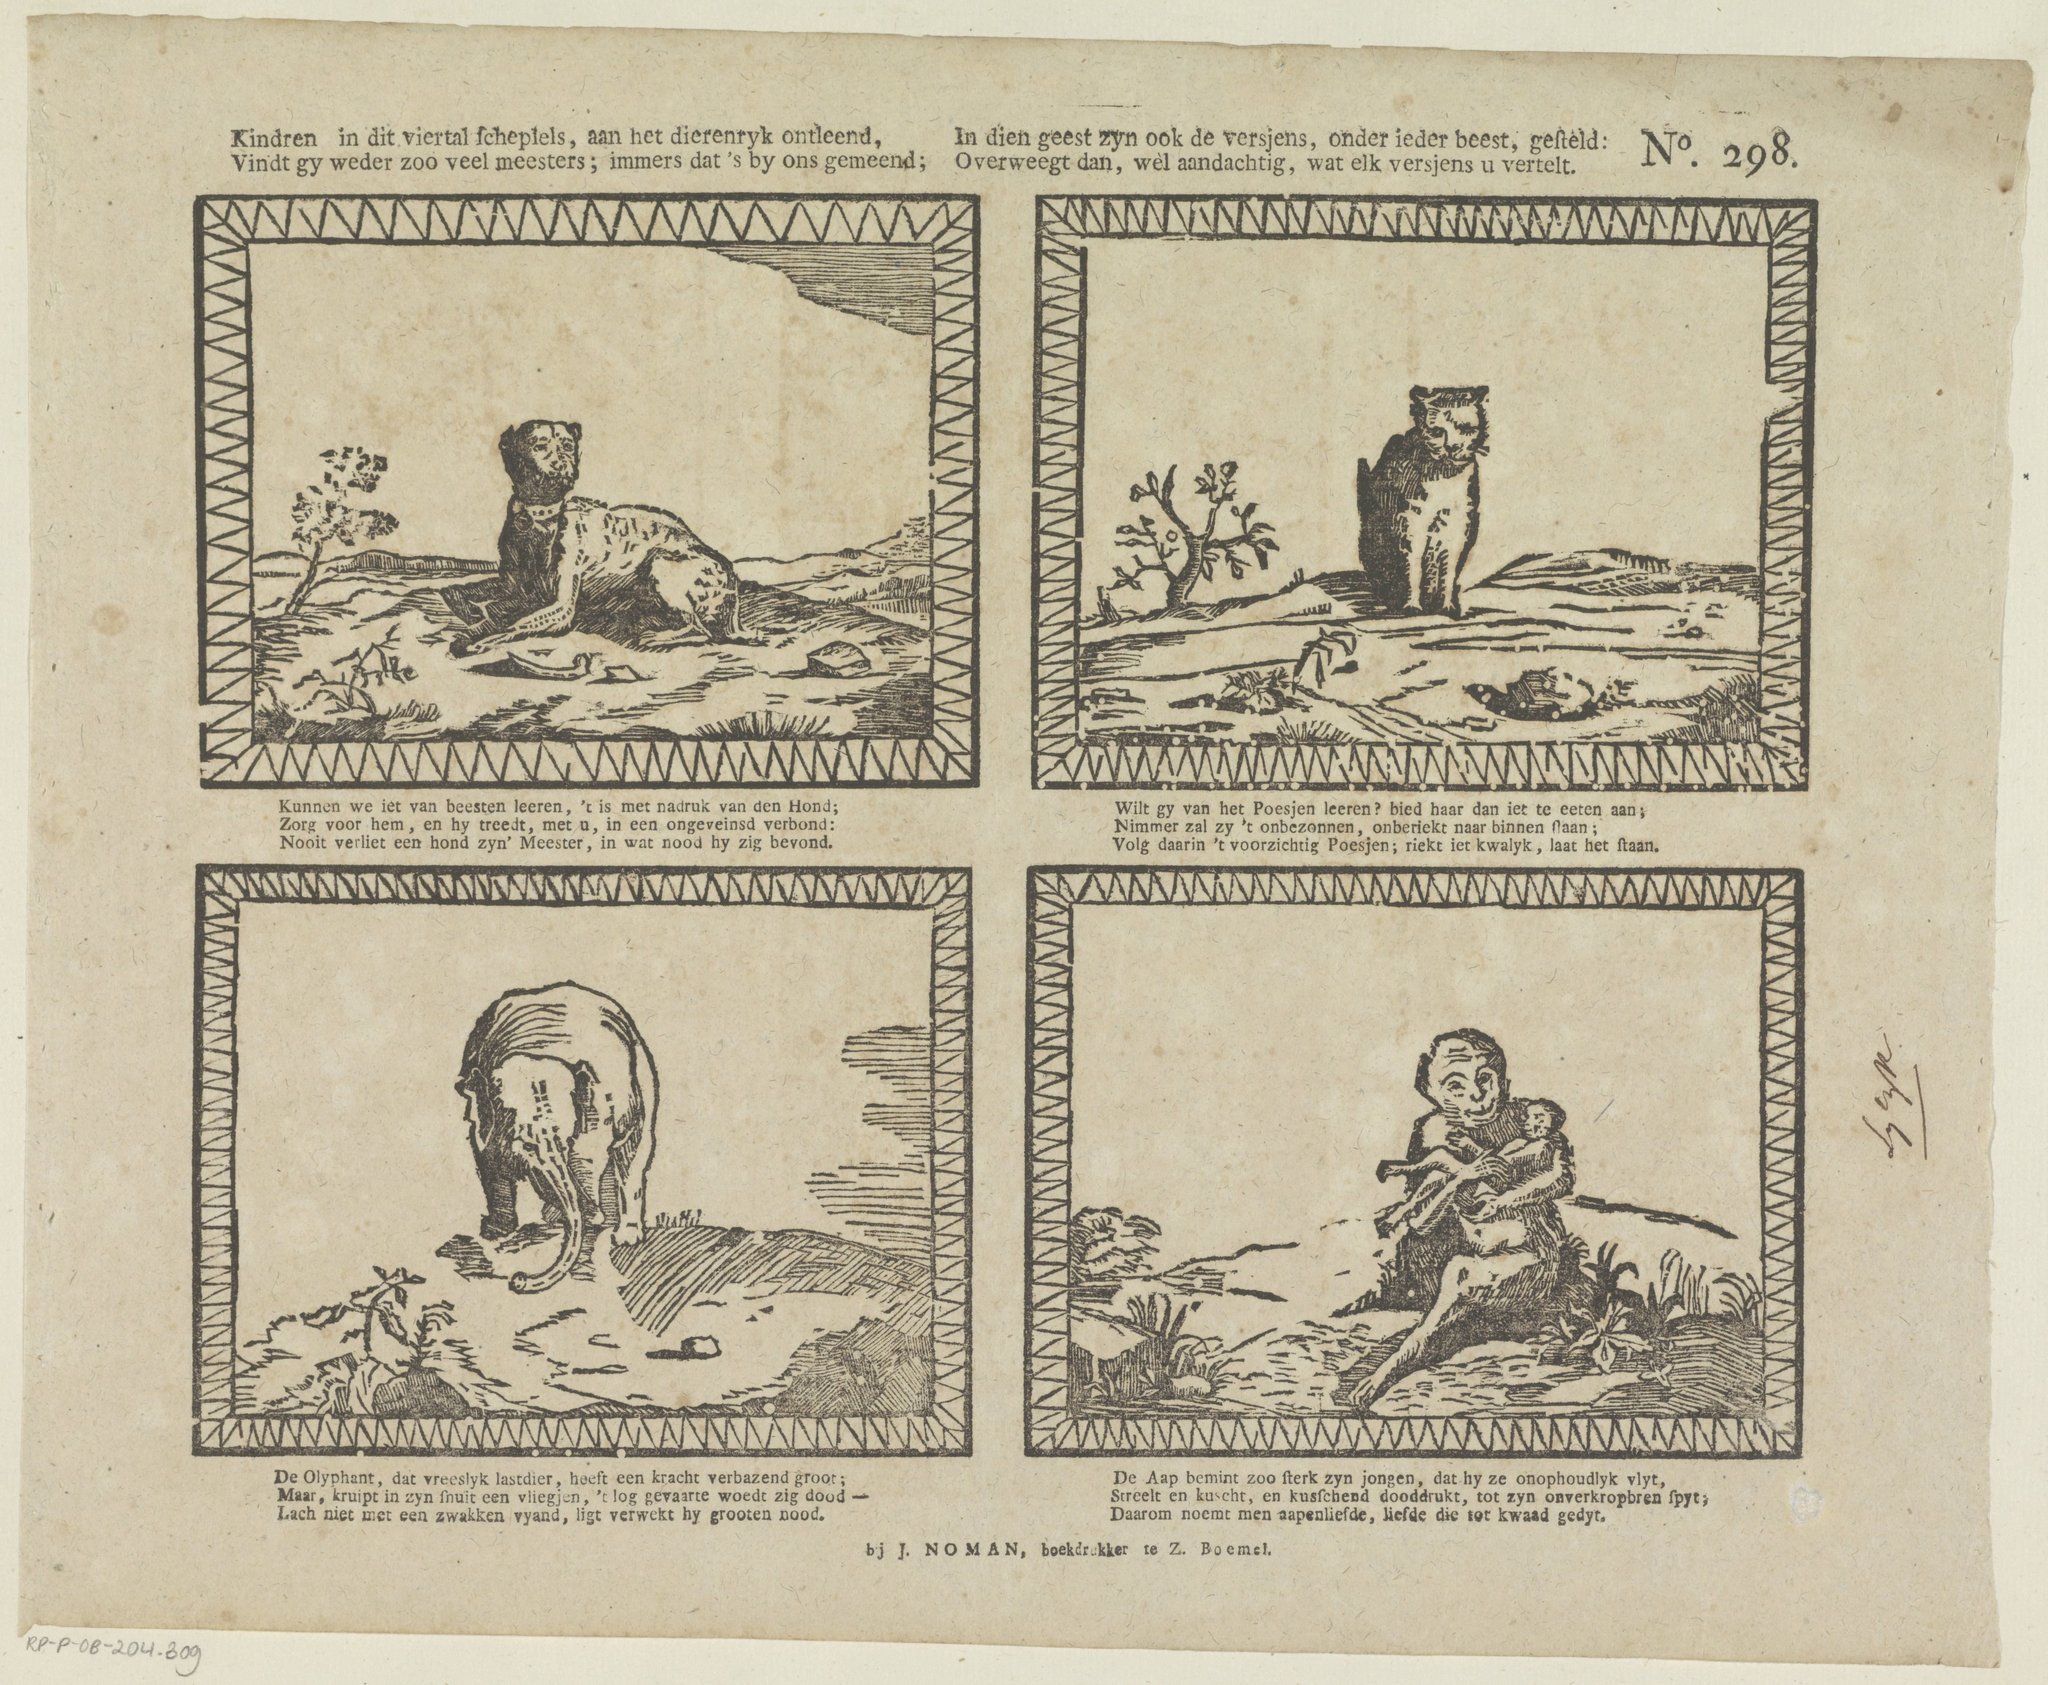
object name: print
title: Kindren in dit viertal schepsels, aan het dierenryk ontleend, / Vindt gy weder zoo veel meesters; immers dat 's by ons gemeend; / In dien geest zyn ook de versjens, onder ieder beest, gesteld: / Overweegt dan, wel aandachtig, wat elk versjen u vertelt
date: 1806-1830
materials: paper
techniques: letterpress printing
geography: netherlands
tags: animals, cat, monkeys, apes, trunked animals: elephant, dog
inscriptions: collector's mark: Lugt 2760, inscription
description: Blad met 4 voorstellingen van een hond, een kat, een olifant en apen. Onder elke afbeelding een onderschrift. Genummerd rechtsboven: No. 298.